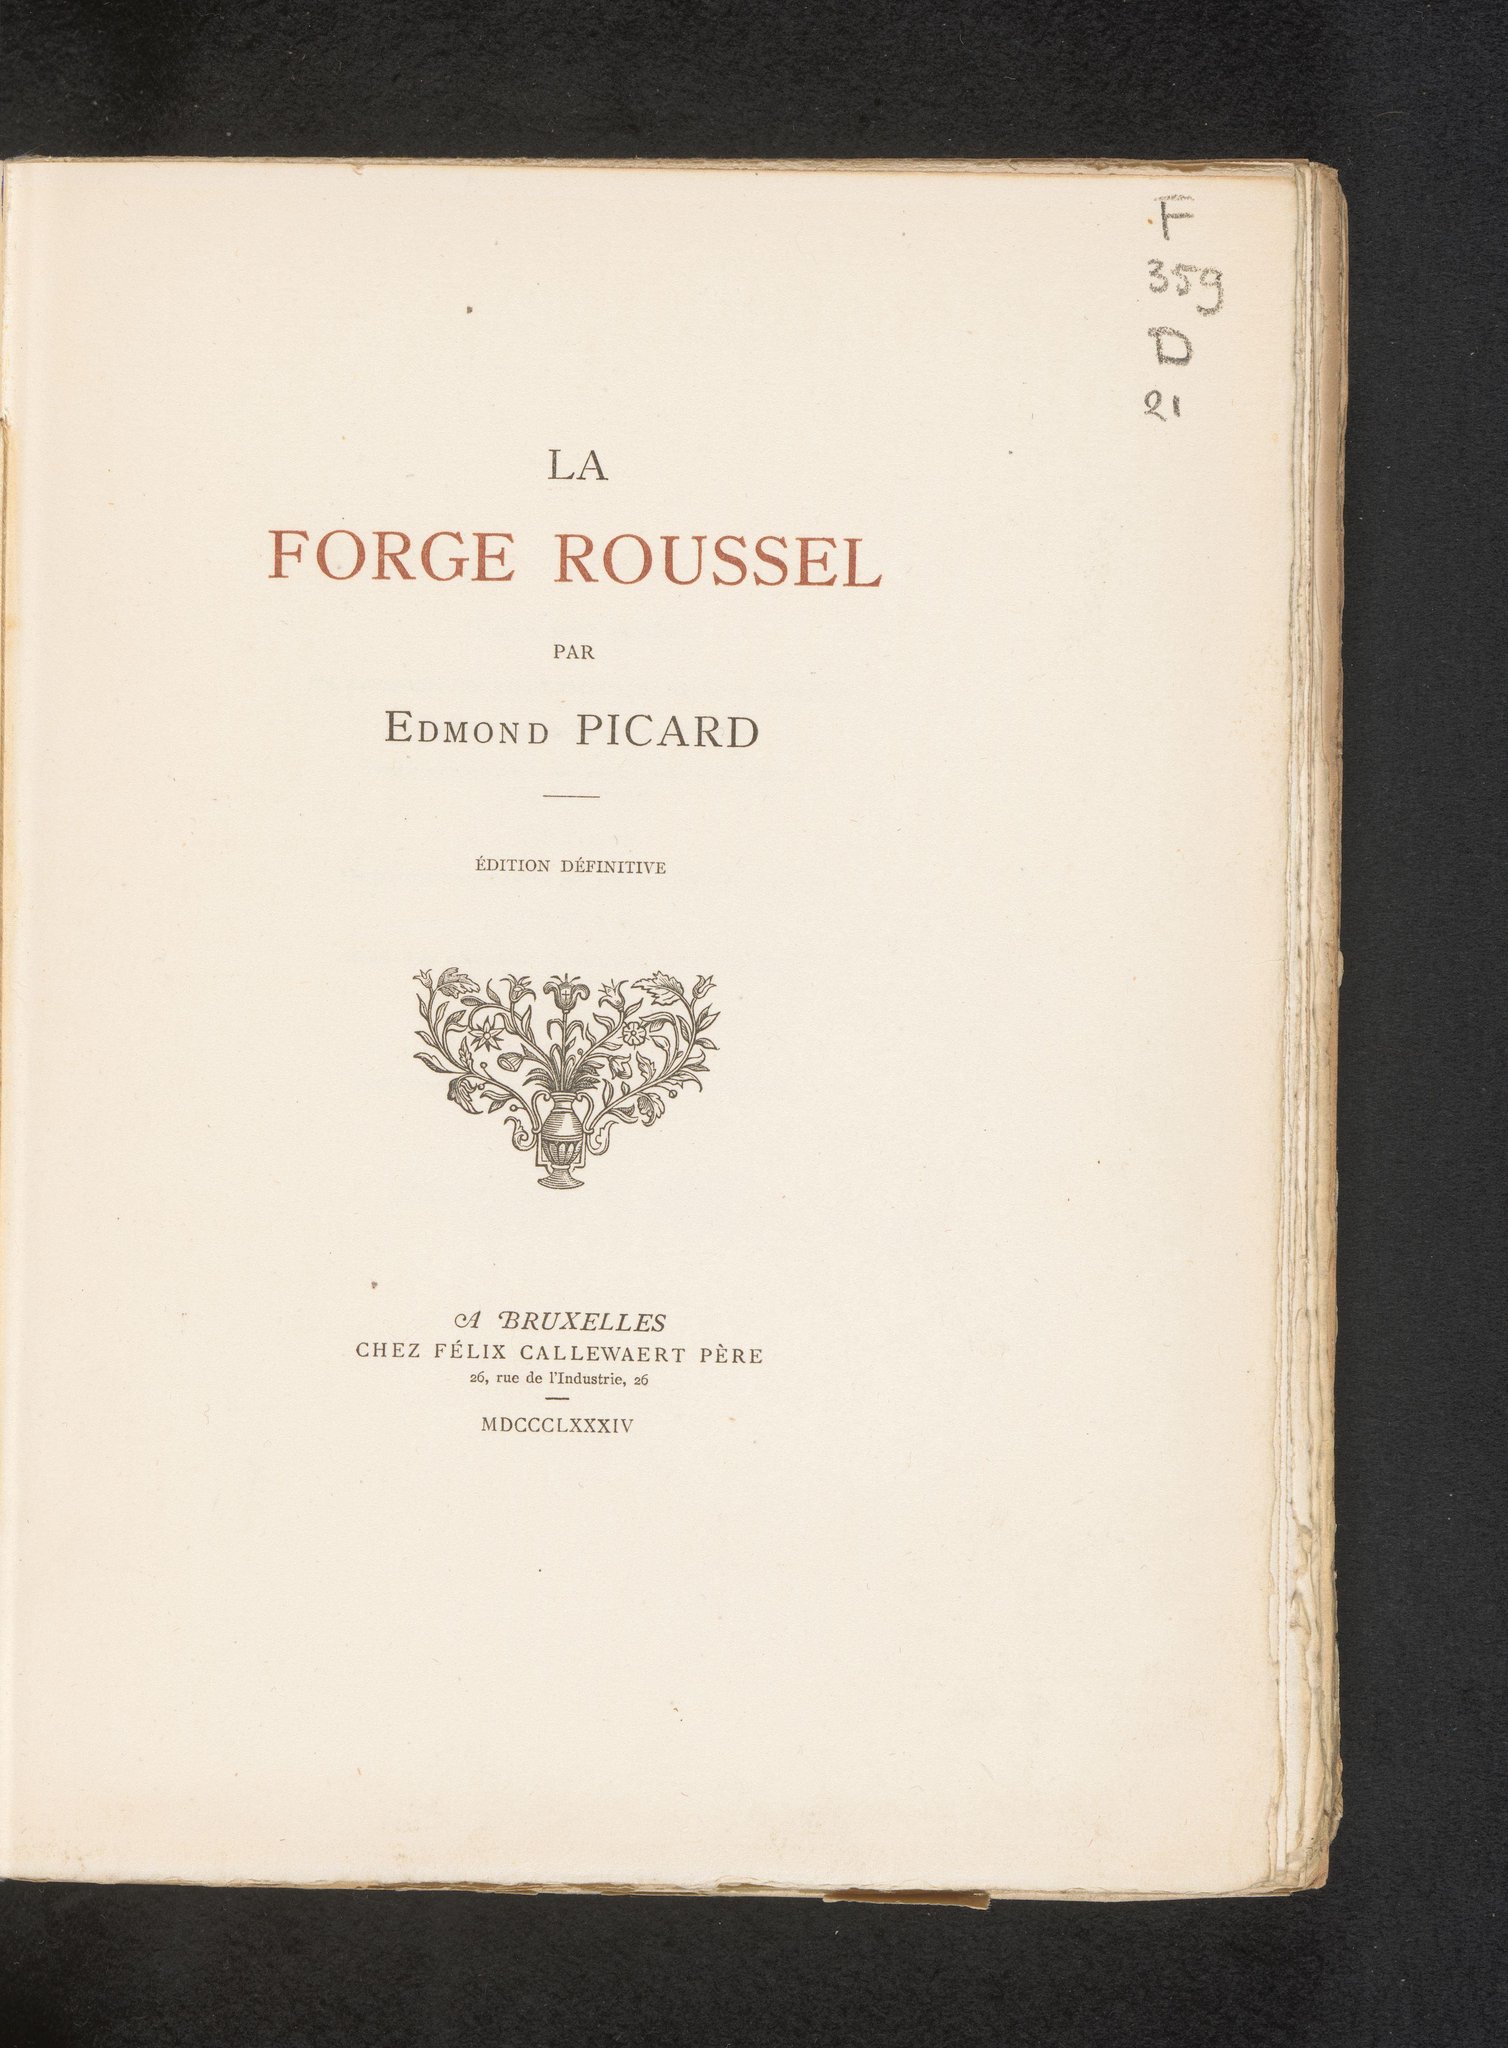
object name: wrapper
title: La forge Roussel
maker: Anonymous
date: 1884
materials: cardboard, ribbon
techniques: combed marbled paper, printing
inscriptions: annotation: ‘JAN/ 1989’, inscription: ‘Édition définitive/ a Bruxelles/ chez Félix Callewaert père/ 26, Rue de l'Industrie 26/ MDCCCLXXXIV’